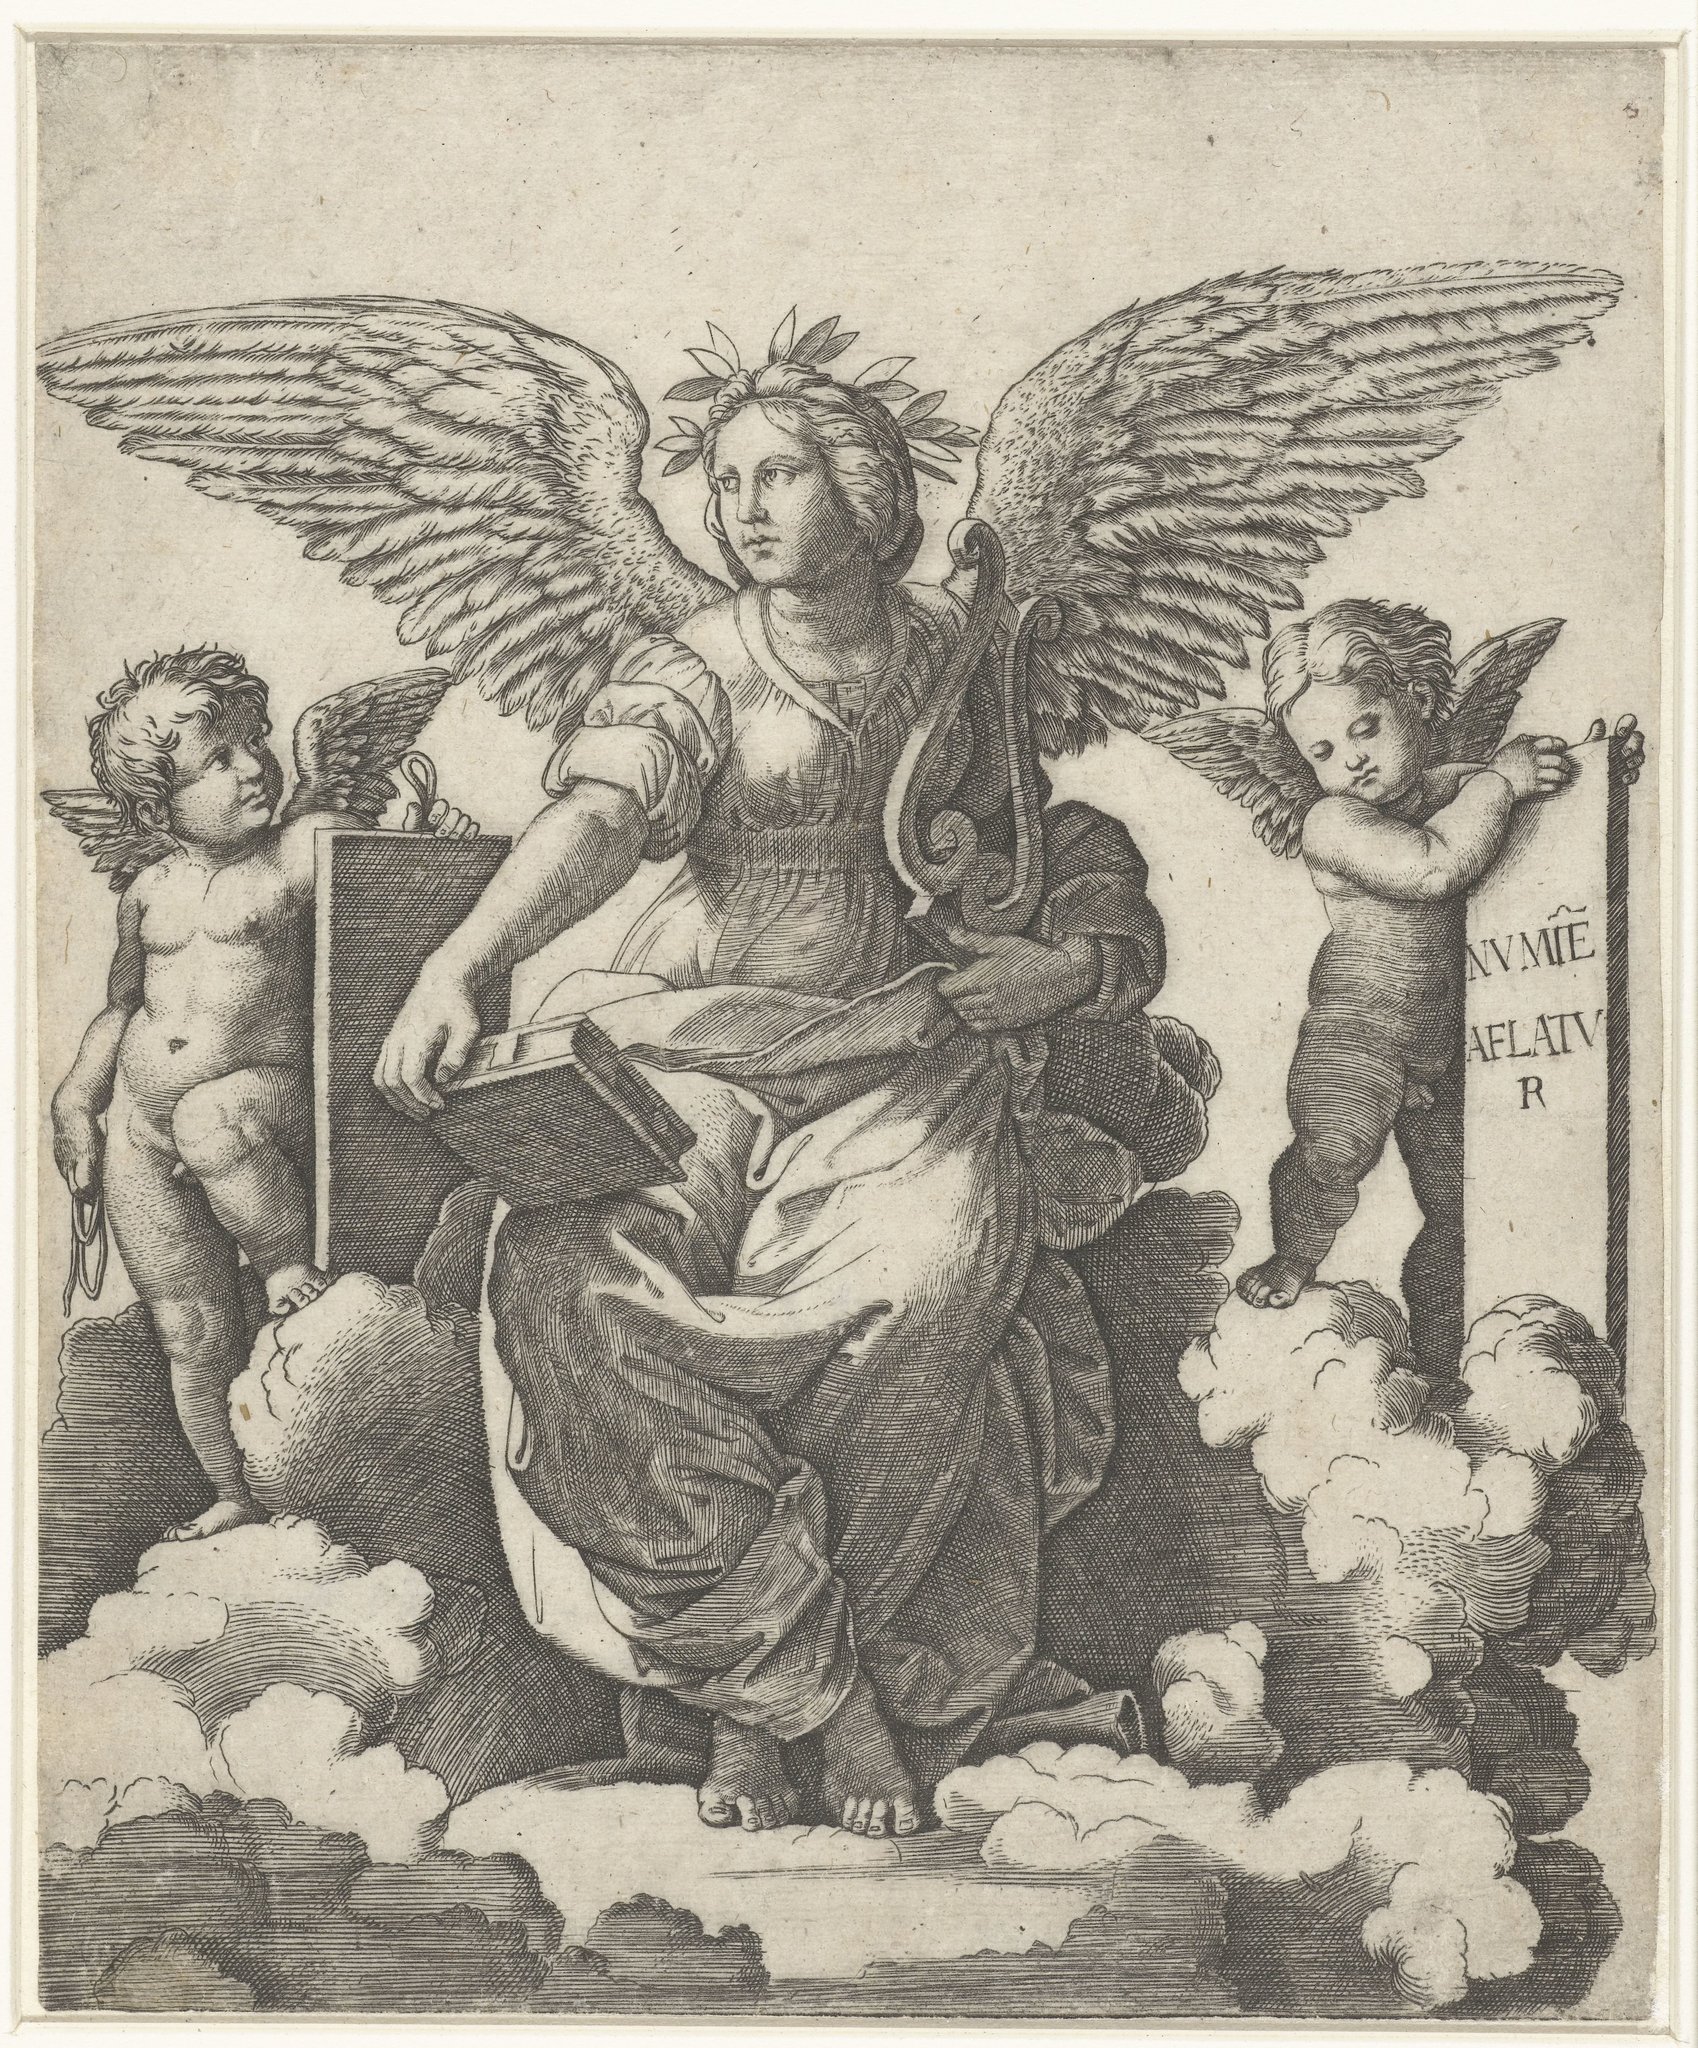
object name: print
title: Gevleugelde vrouw als muze van Poëzie met boek en lier zittend op wolken geflankeerd door putti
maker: marcantonio raimondi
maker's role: print maker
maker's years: 1470-1534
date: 1513-1517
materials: paper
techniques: engraving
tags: (story of the) muses; 'muse' (ripa), symbolic representations, allegories and emblems ~ poetry; 'poesia' (ripa), cupids: 'amores', 'amoretti', 'putti'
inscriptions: collector's mark: Lugt 2228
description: Raimondi liet zich inspireren door een fresco van Raphael op een gewelf in de Stanza della Segnatura. Hij nam de voorstelling niet helemaal letterlijk over (Shoemaker 1981, p. 110).